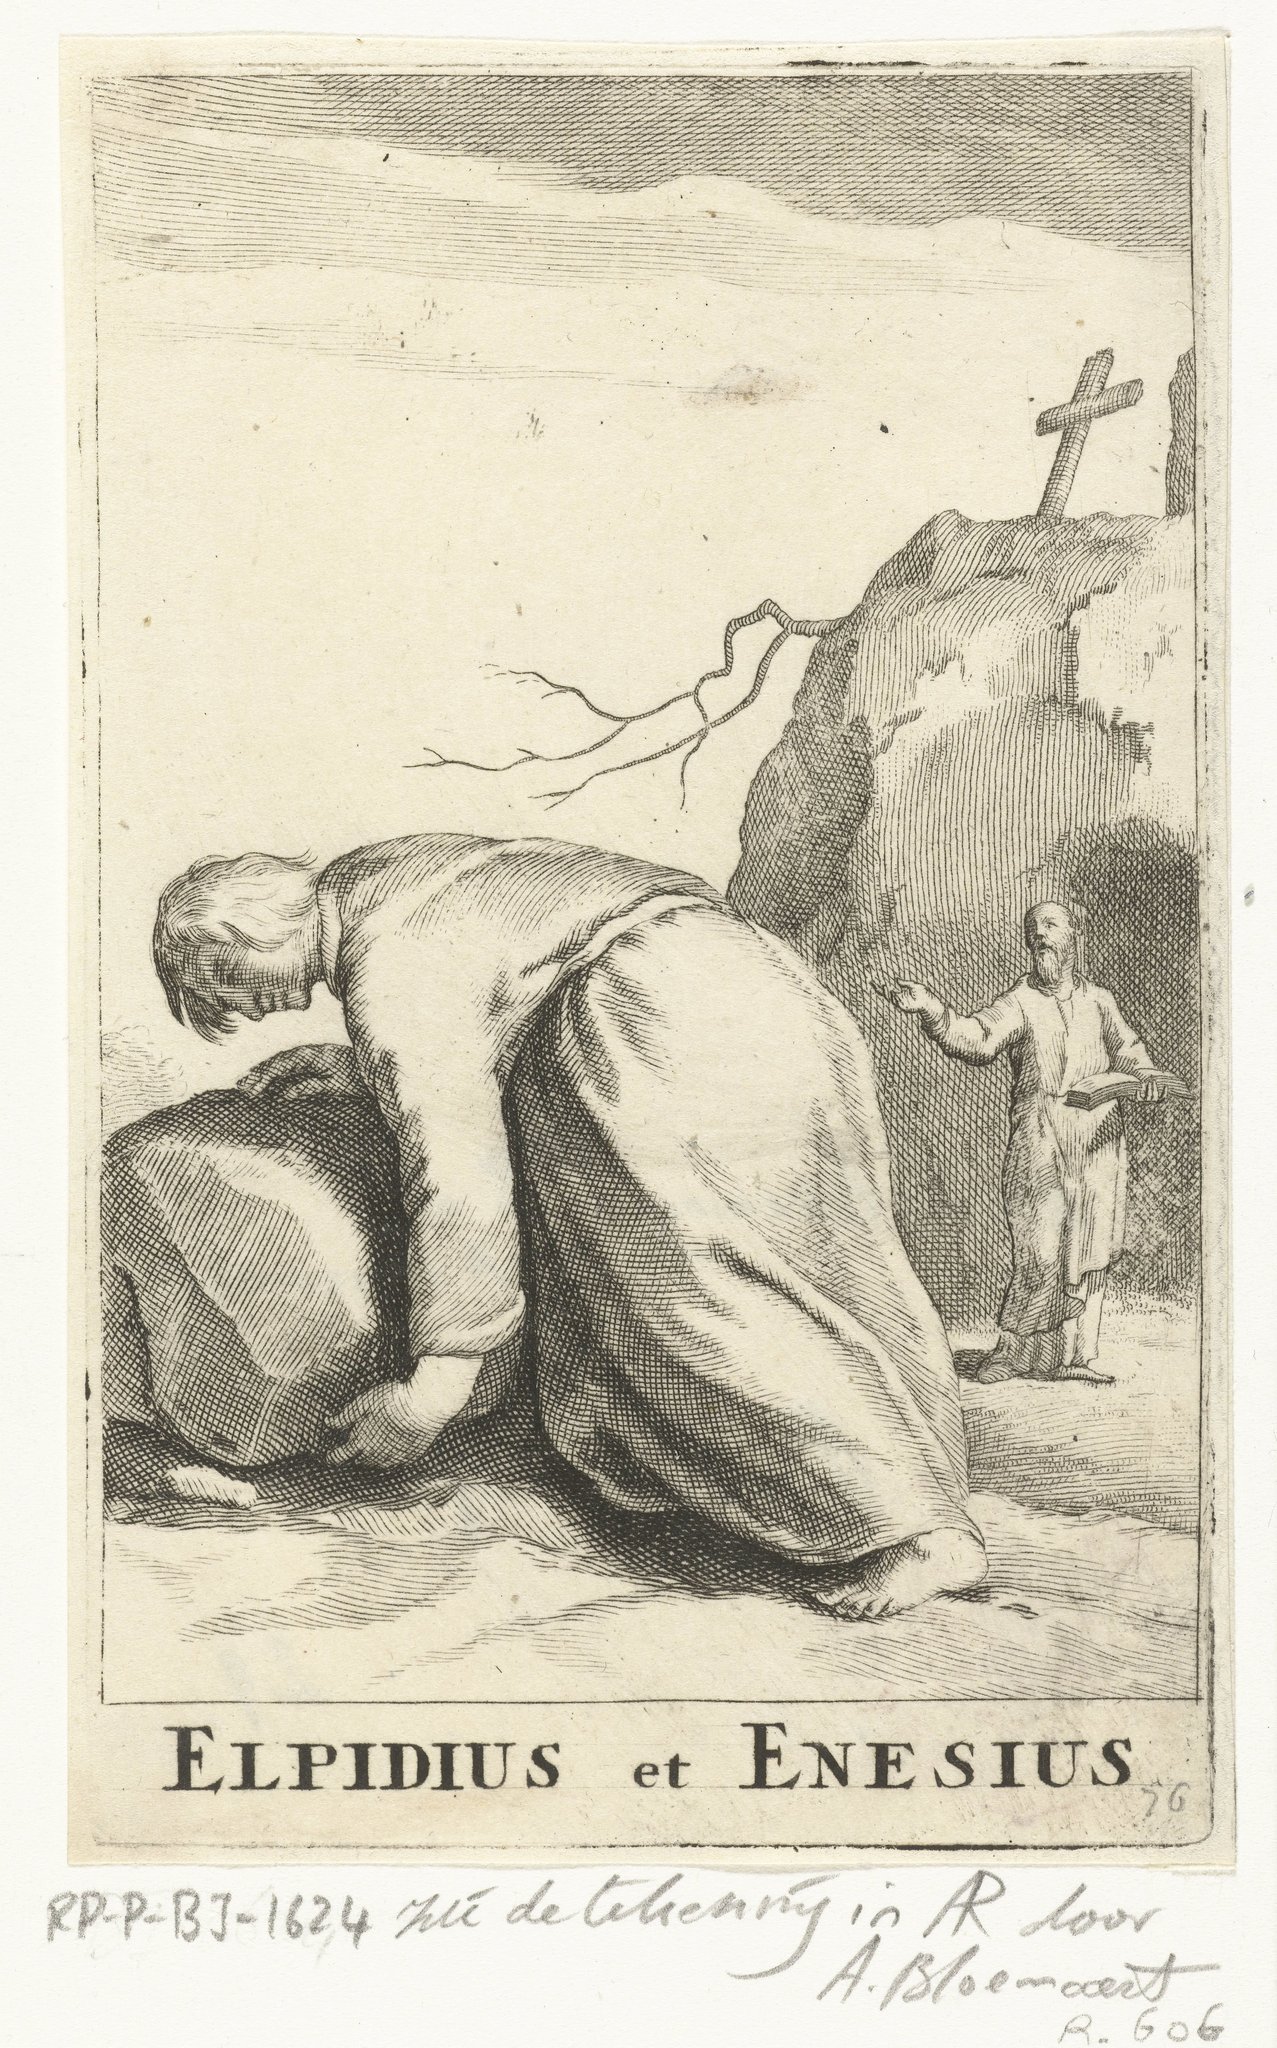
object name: print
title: Kluizenaars: Thebaanse heiligen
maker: frederick bloemaert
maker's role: print maker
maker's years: 1614-1669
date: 1636-1670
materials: paper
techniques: engraving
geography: utrecht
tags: male saints (with name)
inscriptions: number: ‘56’, collector's mark: Lugt 240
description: De heilige Elpidius declameert staande psalmen terwijl hij een schorpioen onder zijn voet vertrapt. De heilige Aenesius, die ook wel een 'athleta Christi' wordt genoemd, doet een gymnastiekoefening.